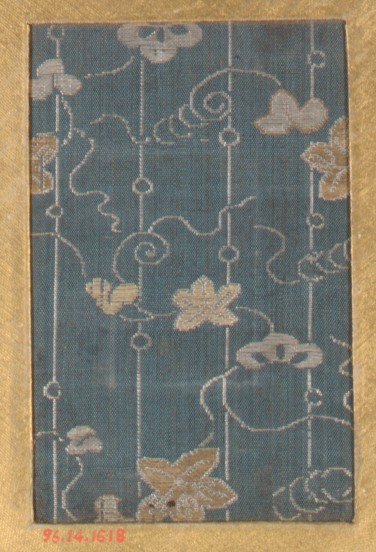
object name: piece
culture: japanese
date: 1701-1900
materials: silk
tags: flowers